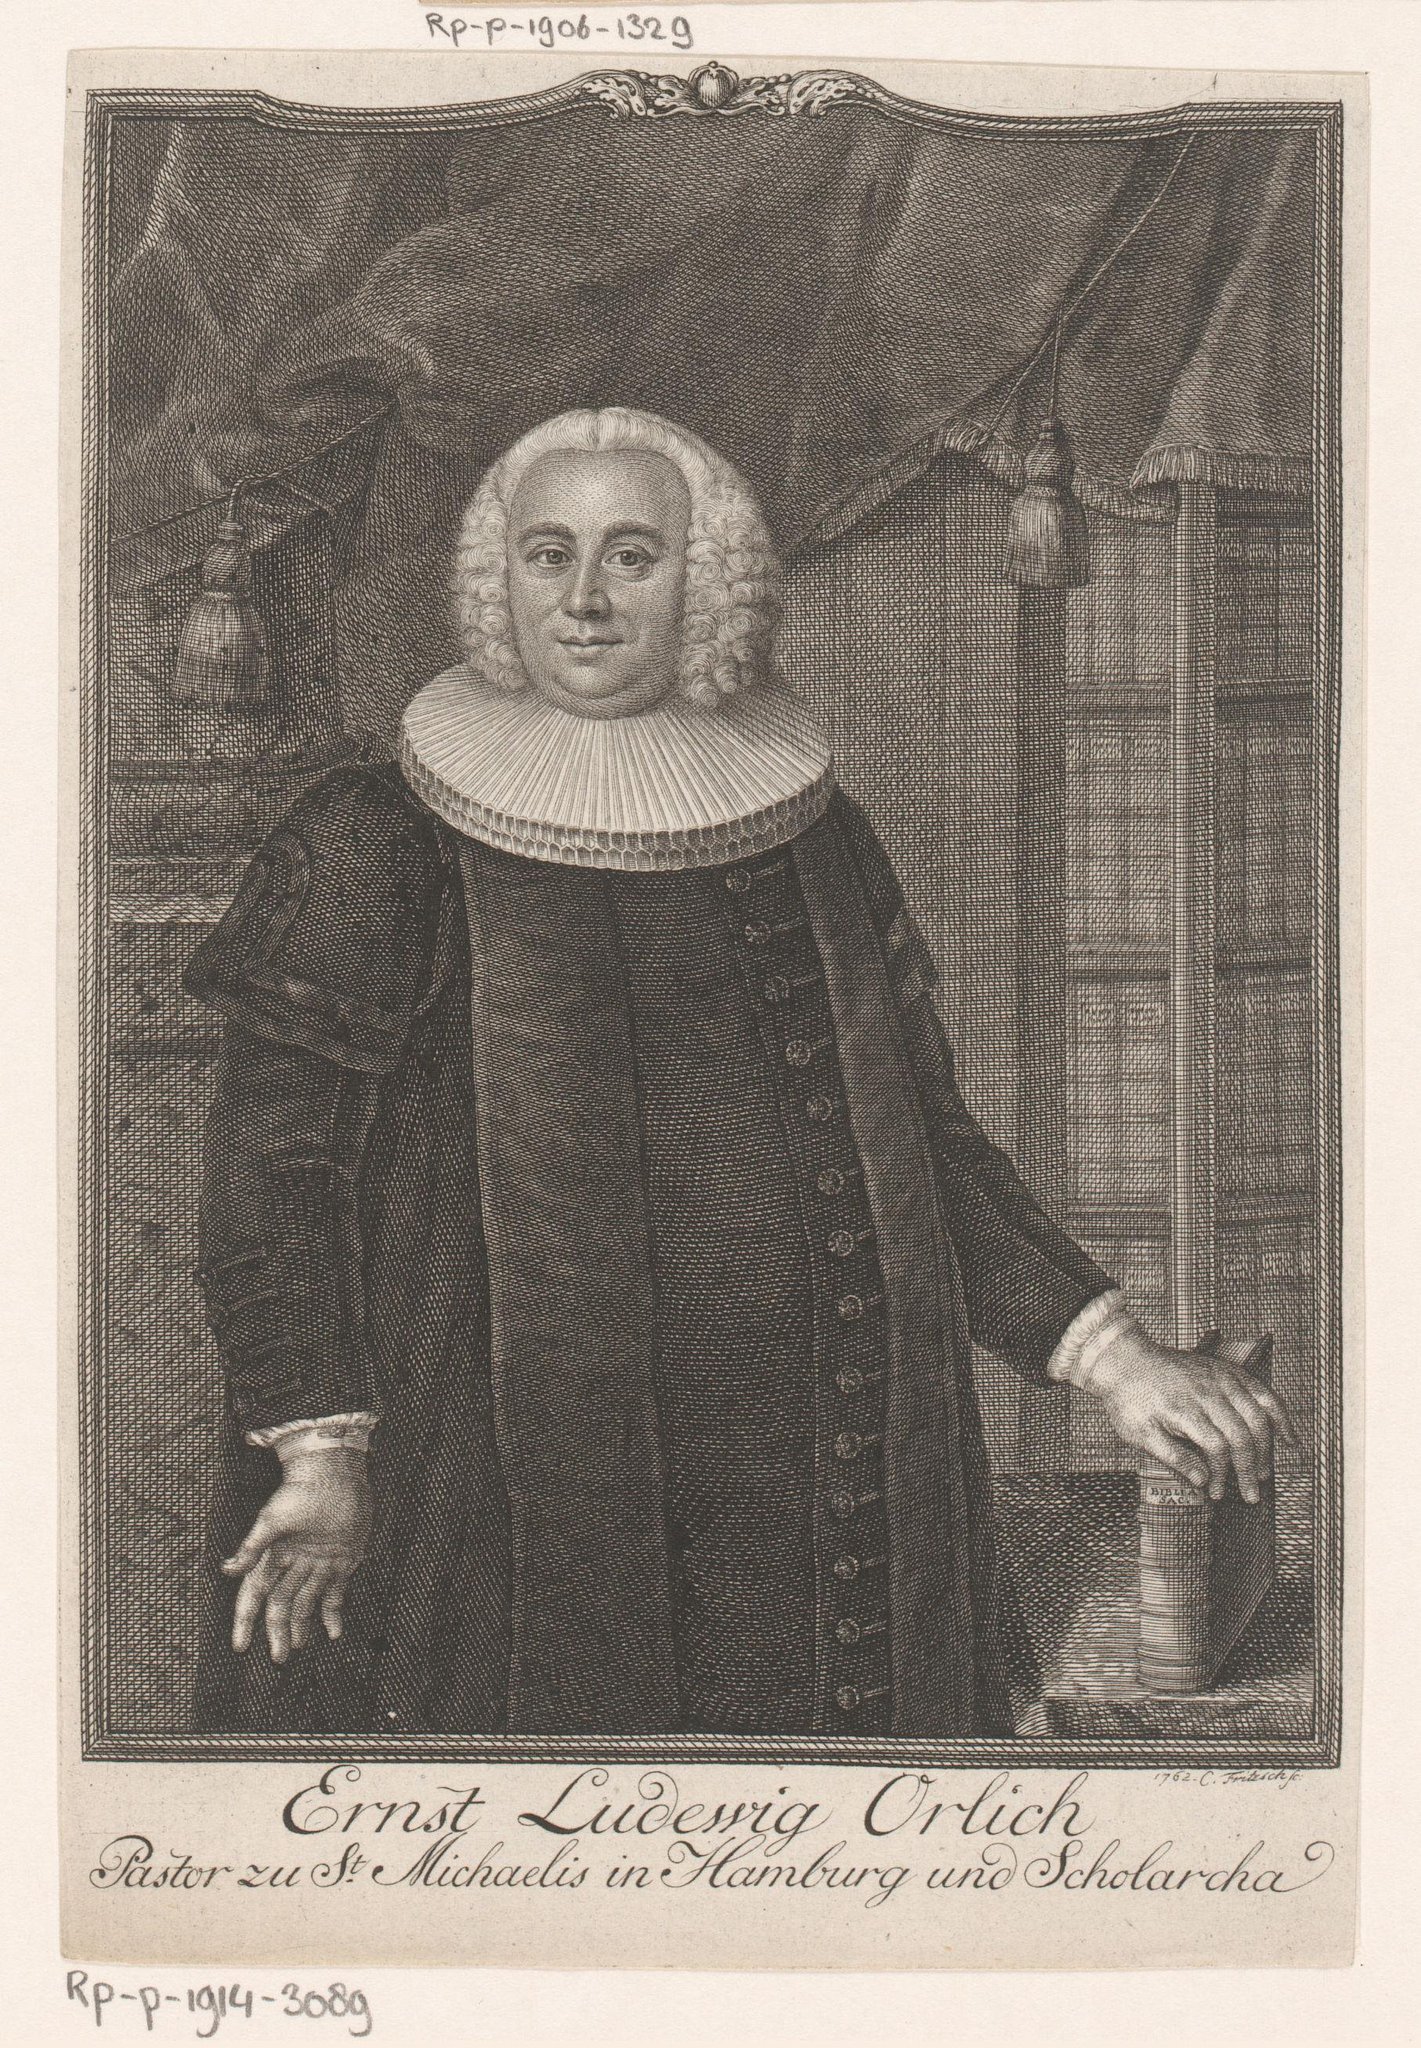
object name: print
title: Portret van Ernst Ludwig Orlich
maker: christian fritzsch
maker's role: print maker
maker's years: 1695-1769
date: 1762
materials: paper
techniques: engraving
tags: bookshelves, historical persons, book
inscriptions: collector's mark: Lugt 2228